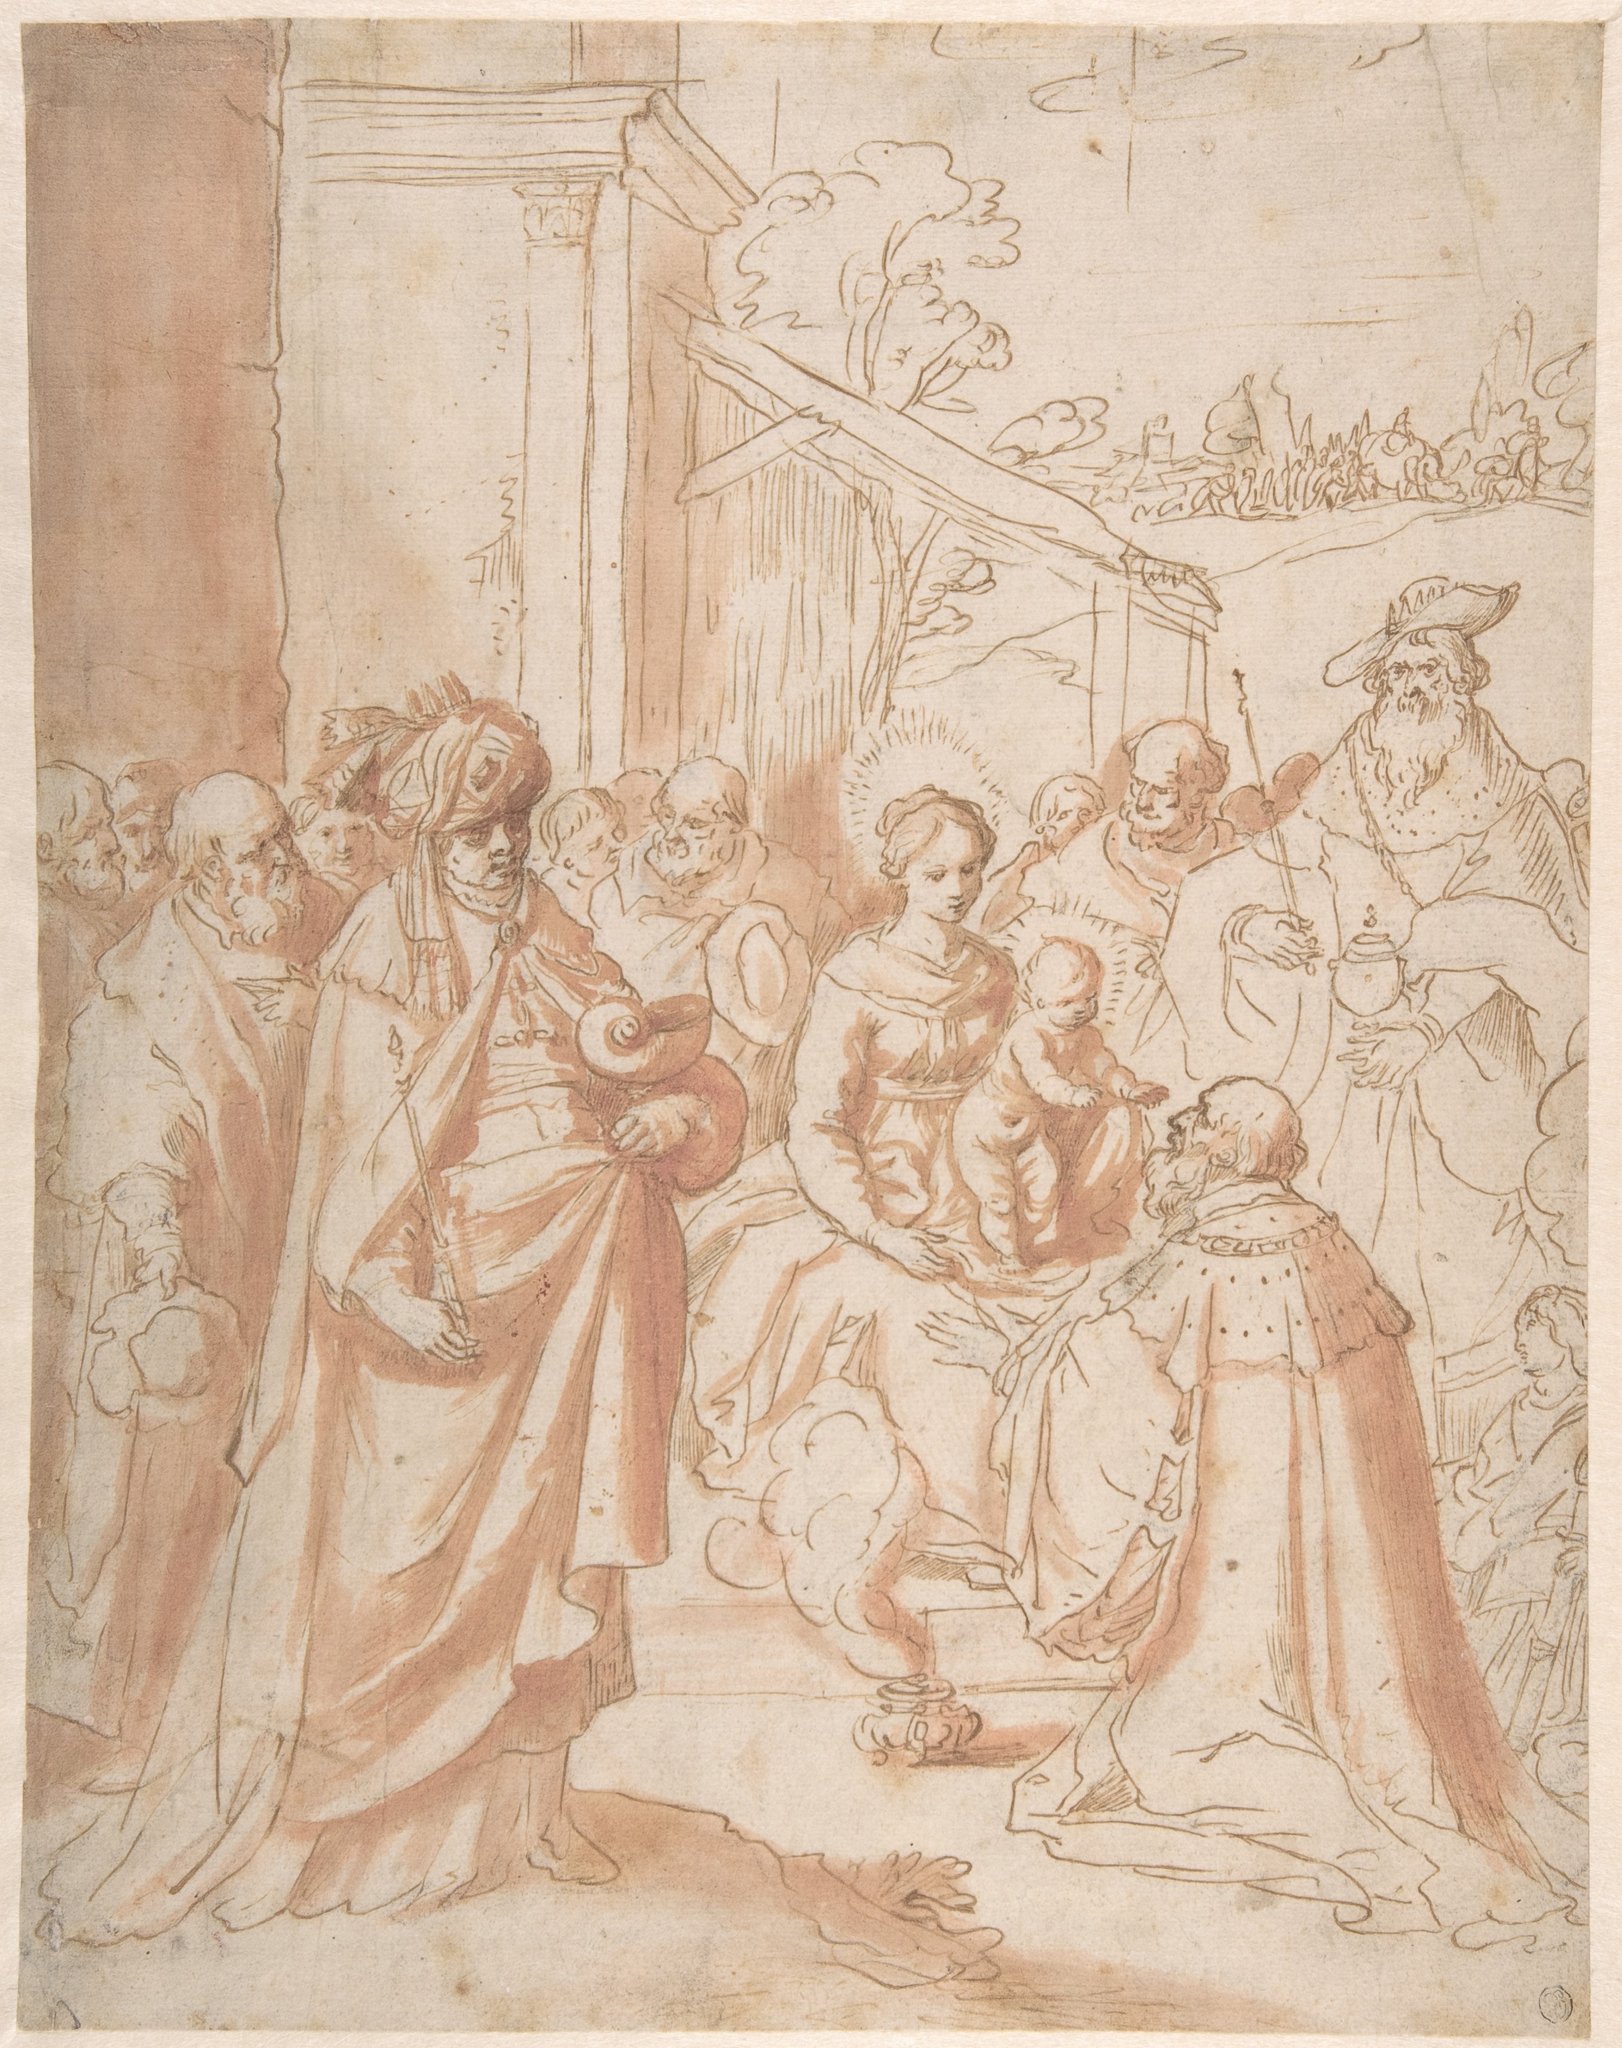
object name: drawing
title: Adoration of the Magi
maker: frans francken ii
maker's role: artist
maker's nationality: flemish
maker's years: 1581-1642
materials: ink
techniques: brush, pen, wash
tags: adoration of the magi